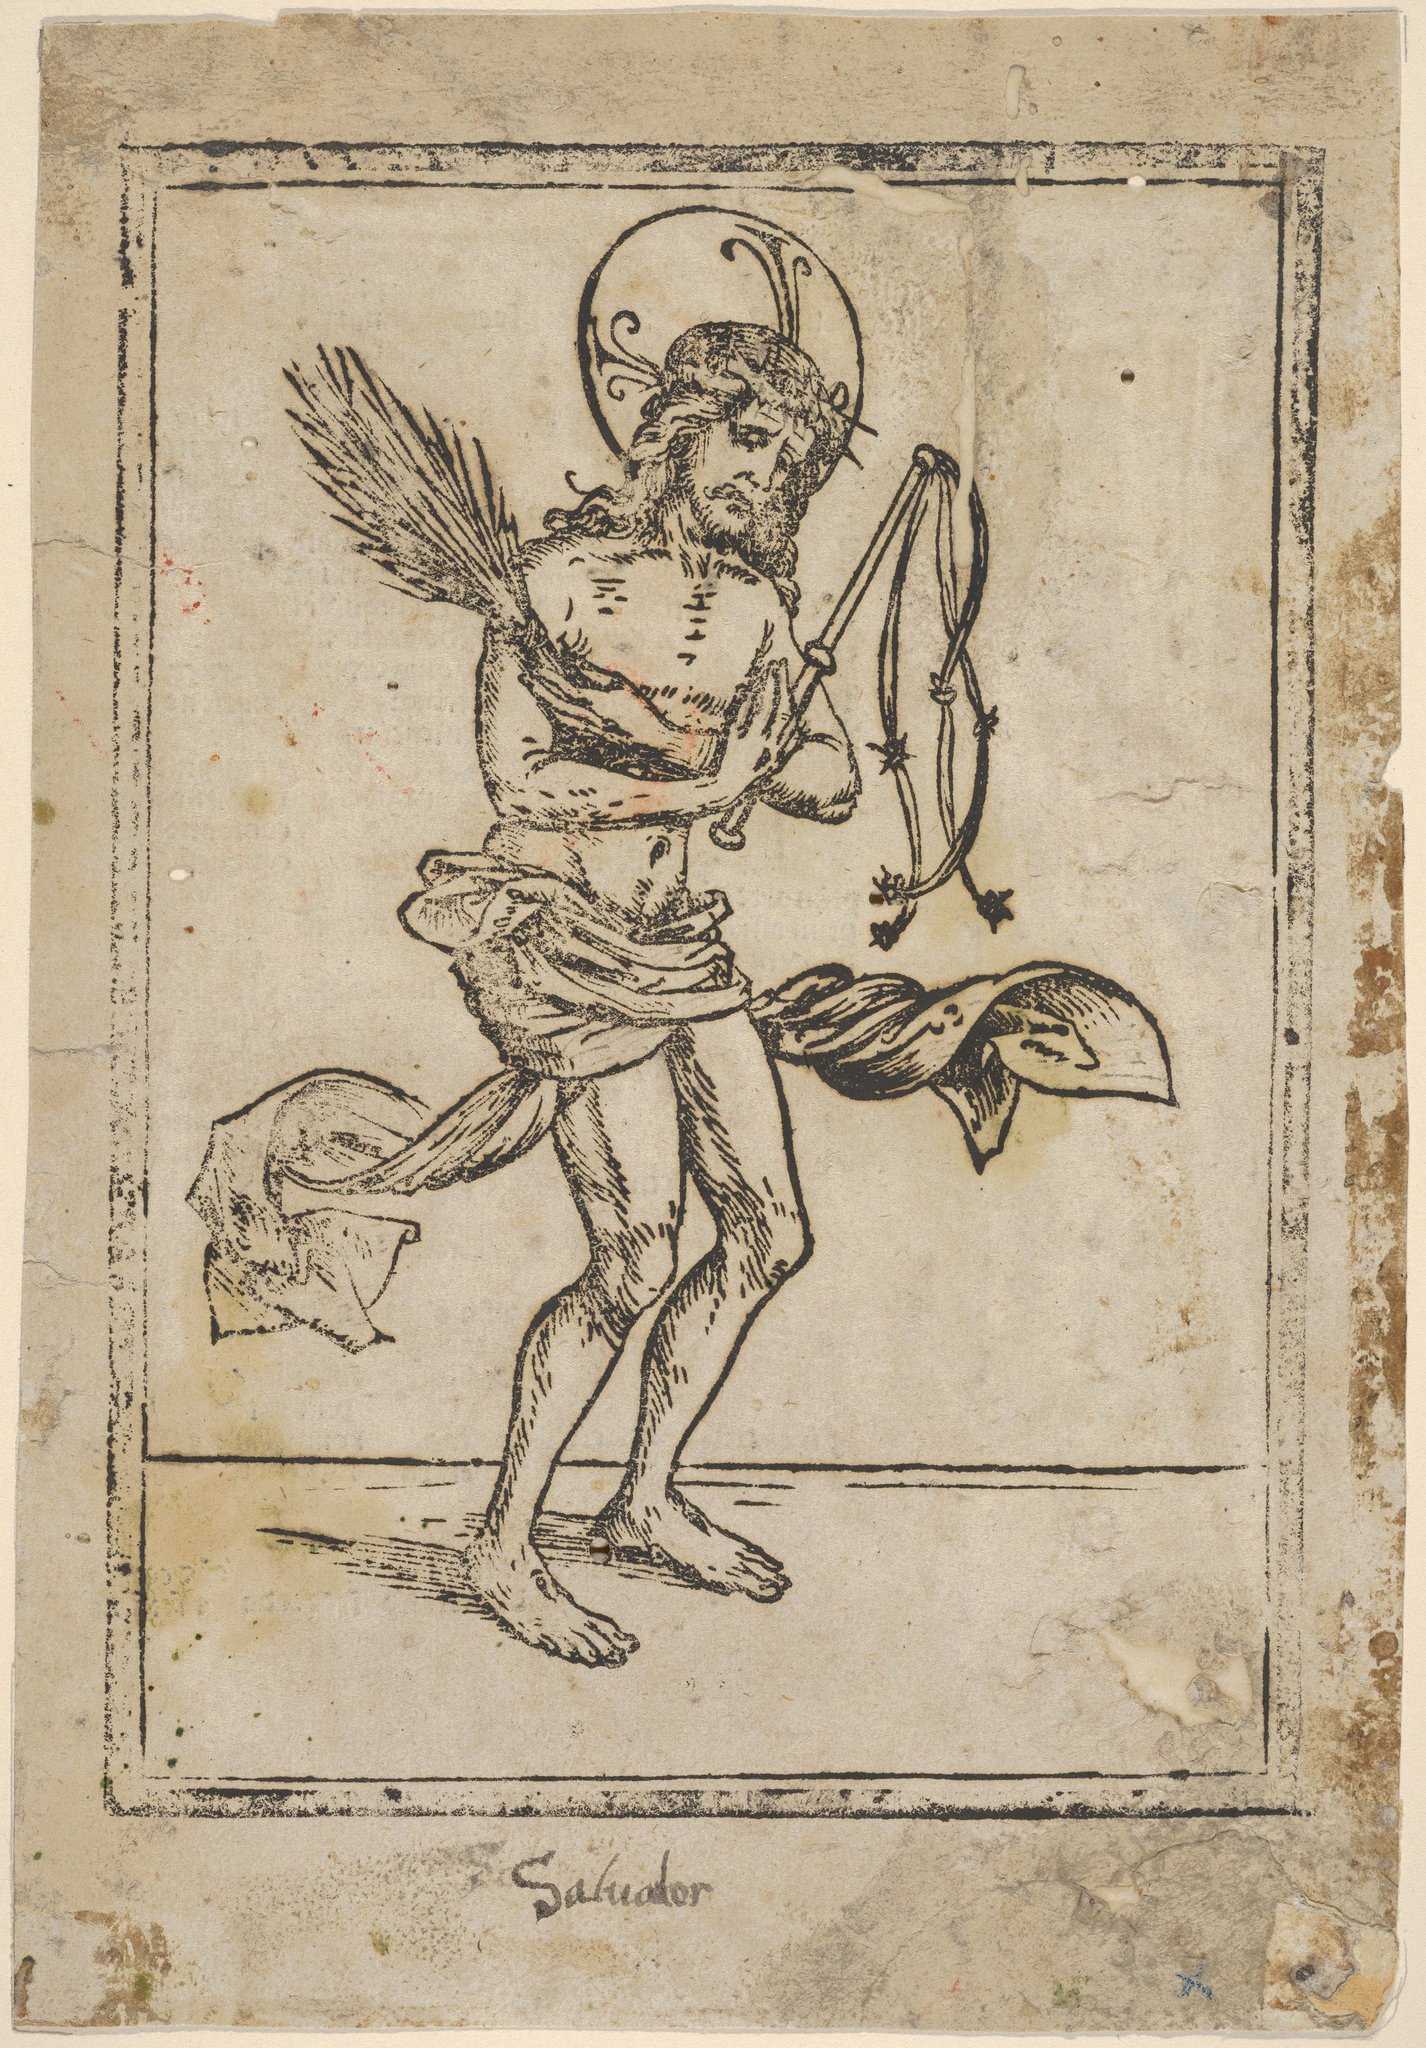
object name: print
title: The Man of Sorrows Standing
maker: hans burgkmair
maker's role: artist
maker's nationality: german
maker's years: 1473-1531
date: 1498-1531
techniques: woodcut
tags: sadness,christ